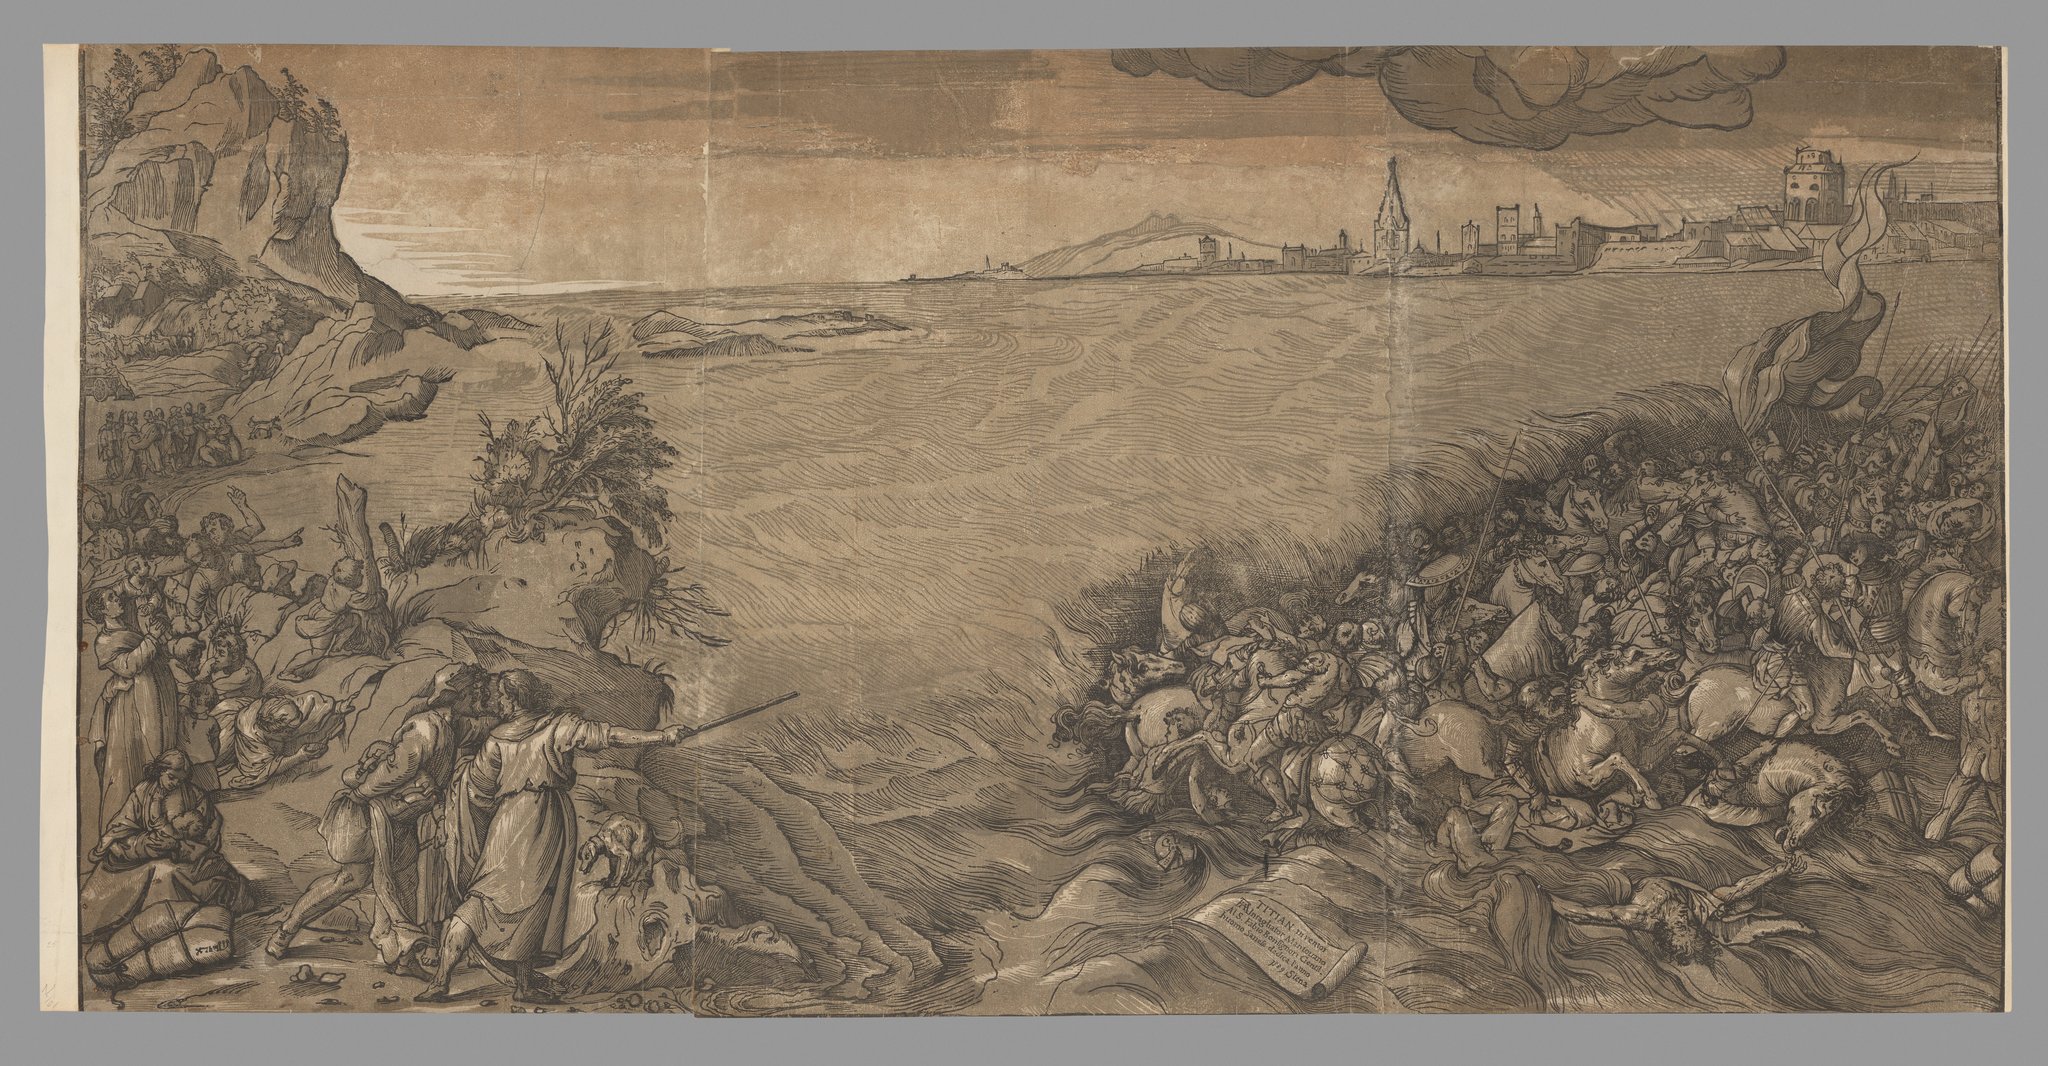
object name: print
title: The crossing of the red sea, Moses stands at the left pointing to the army being submerged, after Titian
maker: andrea andreani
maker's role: artist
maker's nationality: italian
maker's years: 1558-1629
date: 1589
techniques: woodcut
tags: men,horses,moses